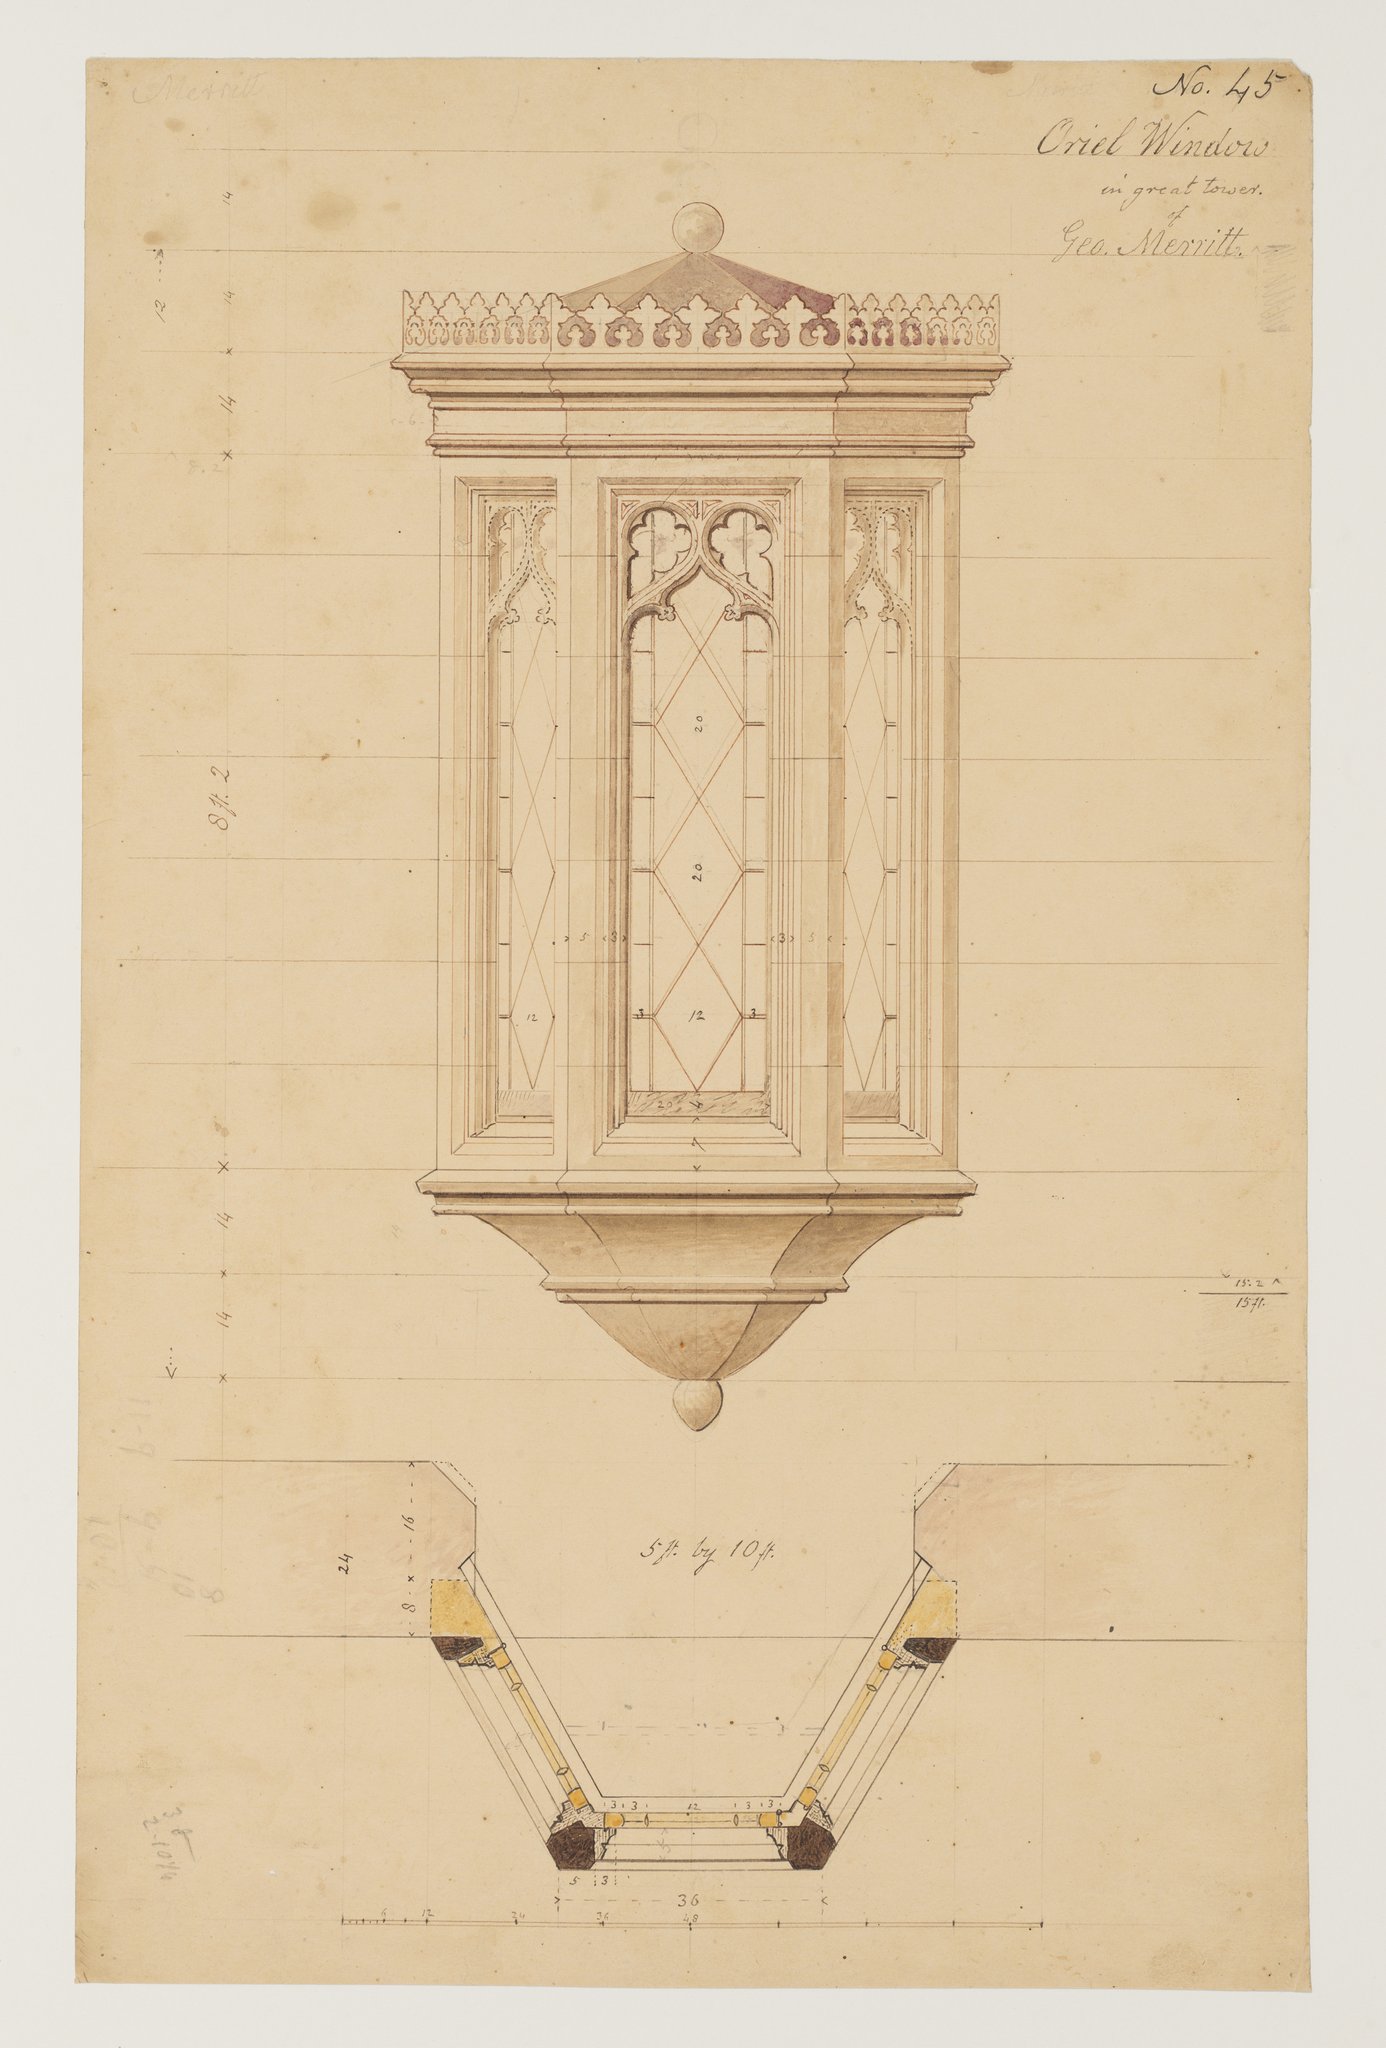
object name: drawing ornament architecture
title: Technical Drawing with the Elevation and Plan of an Oriel Window for the Tower of Lyndhurst for George Merritt, Tarrytown, New York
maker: alexander jackson davis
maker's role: artist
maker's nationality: american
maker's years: 1803-1892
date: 1864-1865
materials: graphite, ink, watercolor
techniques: pen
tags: windows